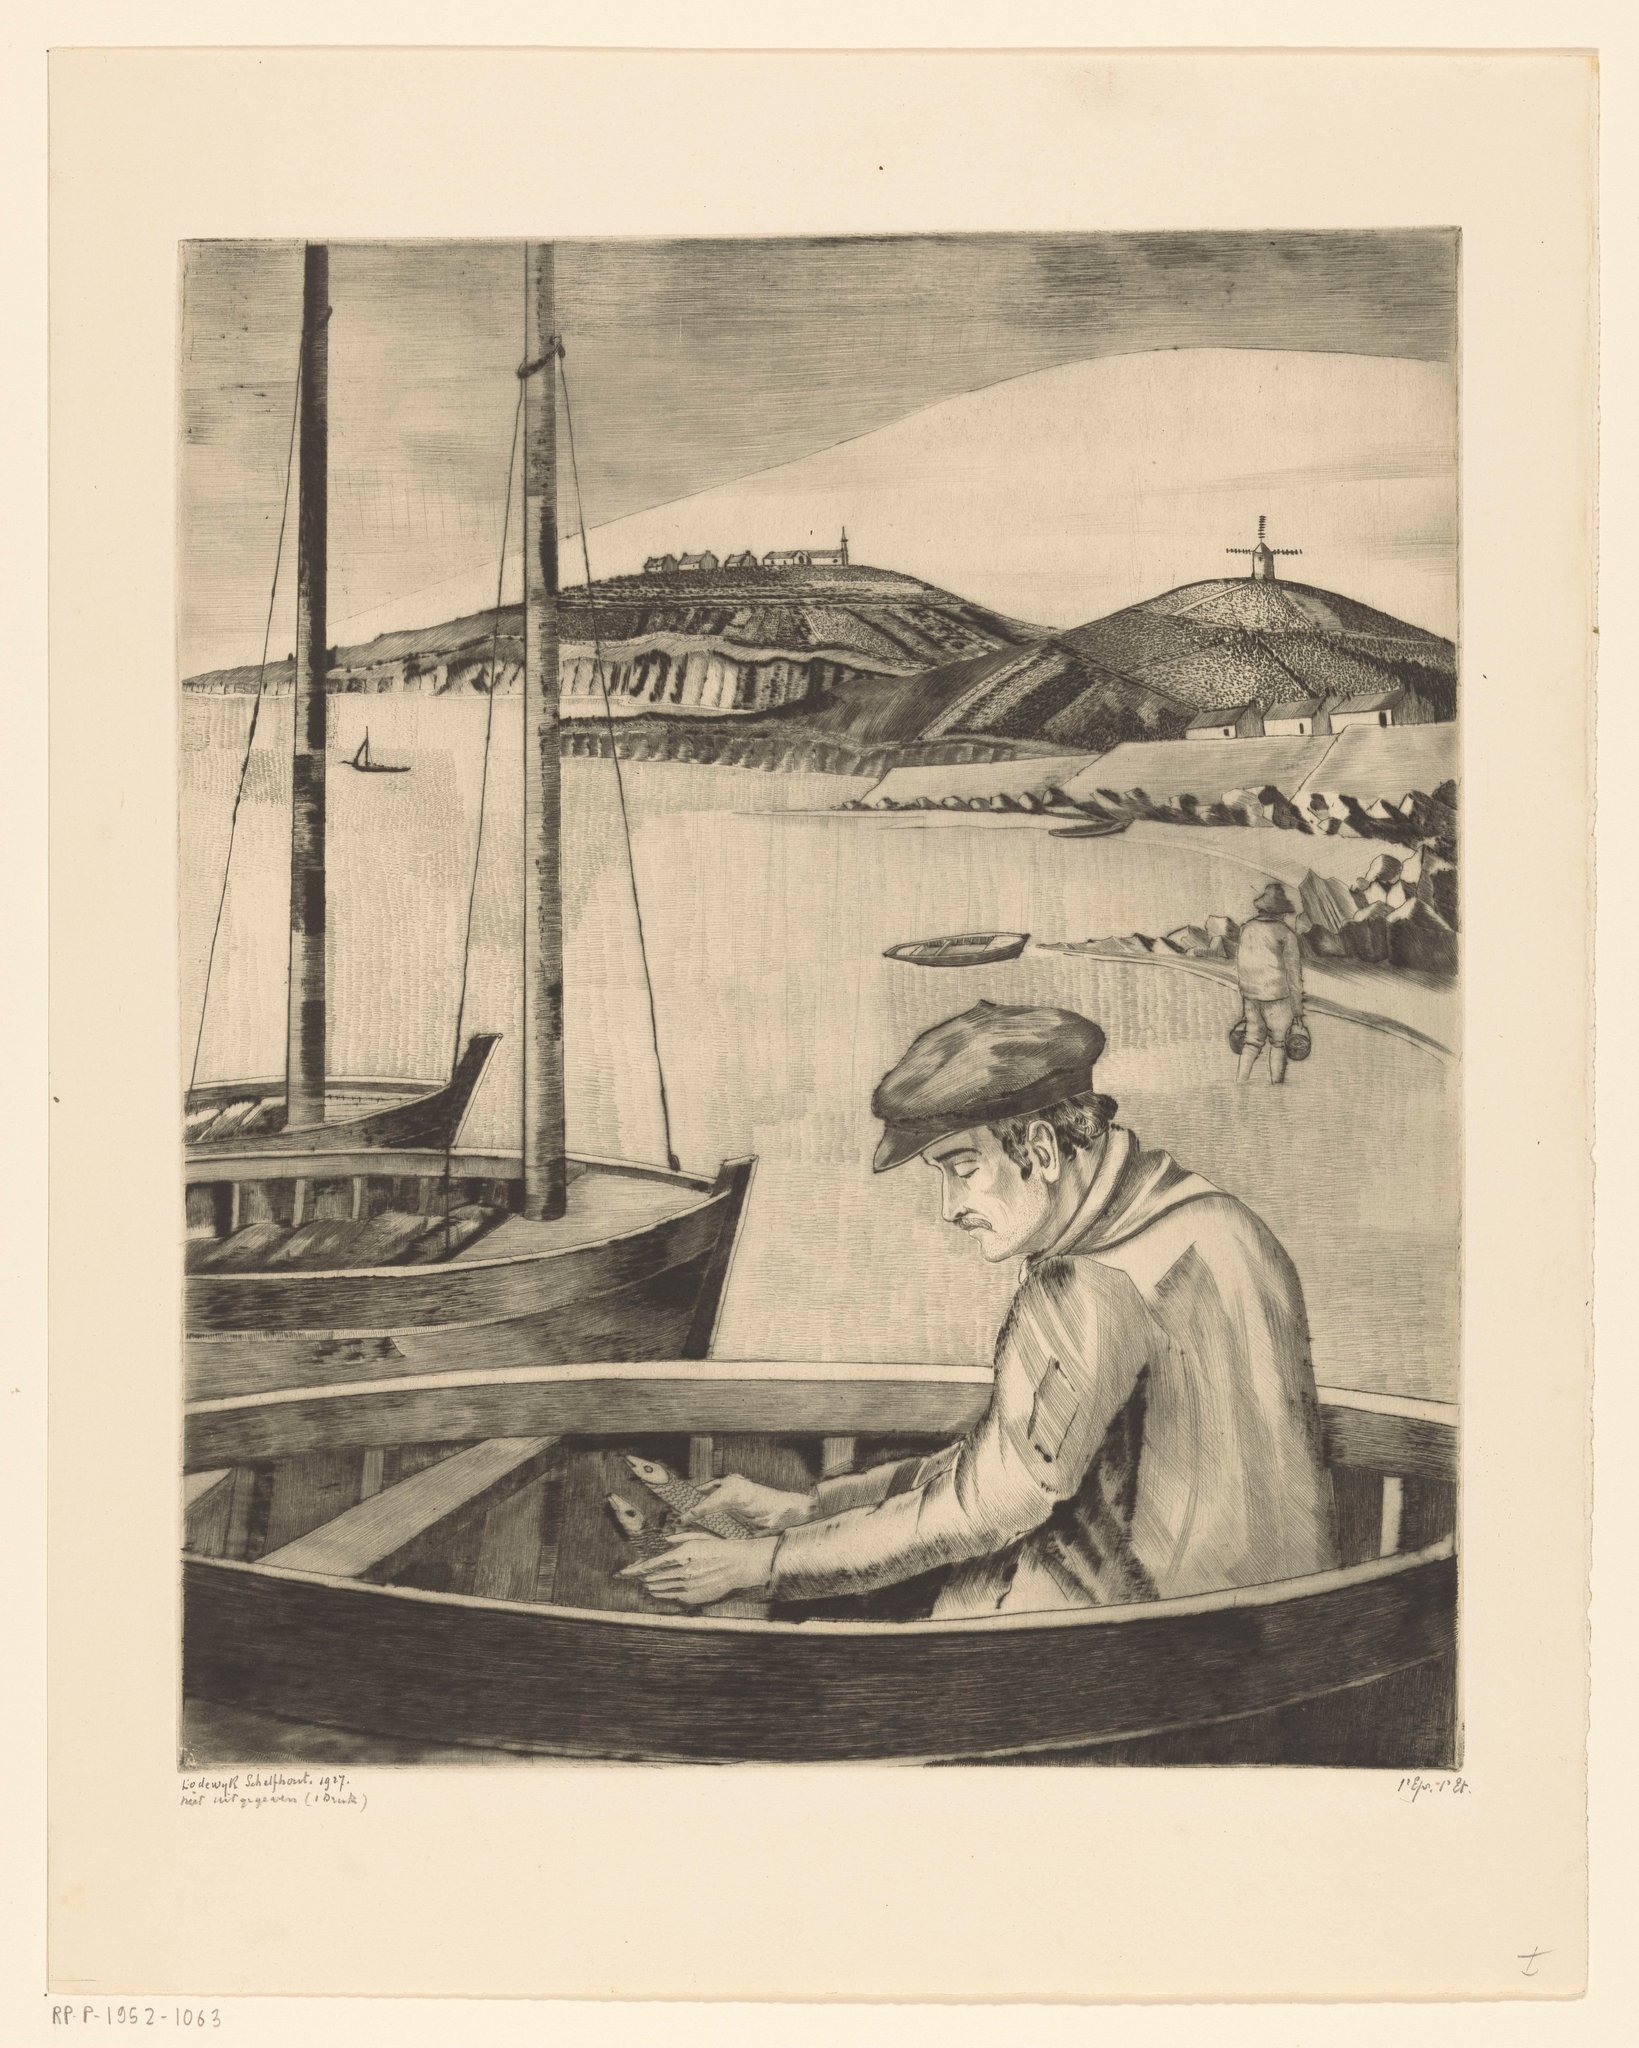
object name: print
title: Visser in een afgemeerd schip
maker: lodewijk schelfhout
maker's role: draughtsman, print maker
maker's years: 1881-1943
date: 1927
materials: paper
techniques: drypoint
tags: fishes, ships (in general), coast, fisherman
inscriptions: inscription: ‘niet uitgegeven’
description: Op de voorgrond een visser in een afgemeerd schip. Hij draagt een pet en heeft twee vissen in zijn handen. Achter het schip bevinden zich nog twee afgemeerde schepen. Op de achtergrond een heuvellandschap met een kerk, huizen en een molen aan zee. In zee een man die twee manden draagt.